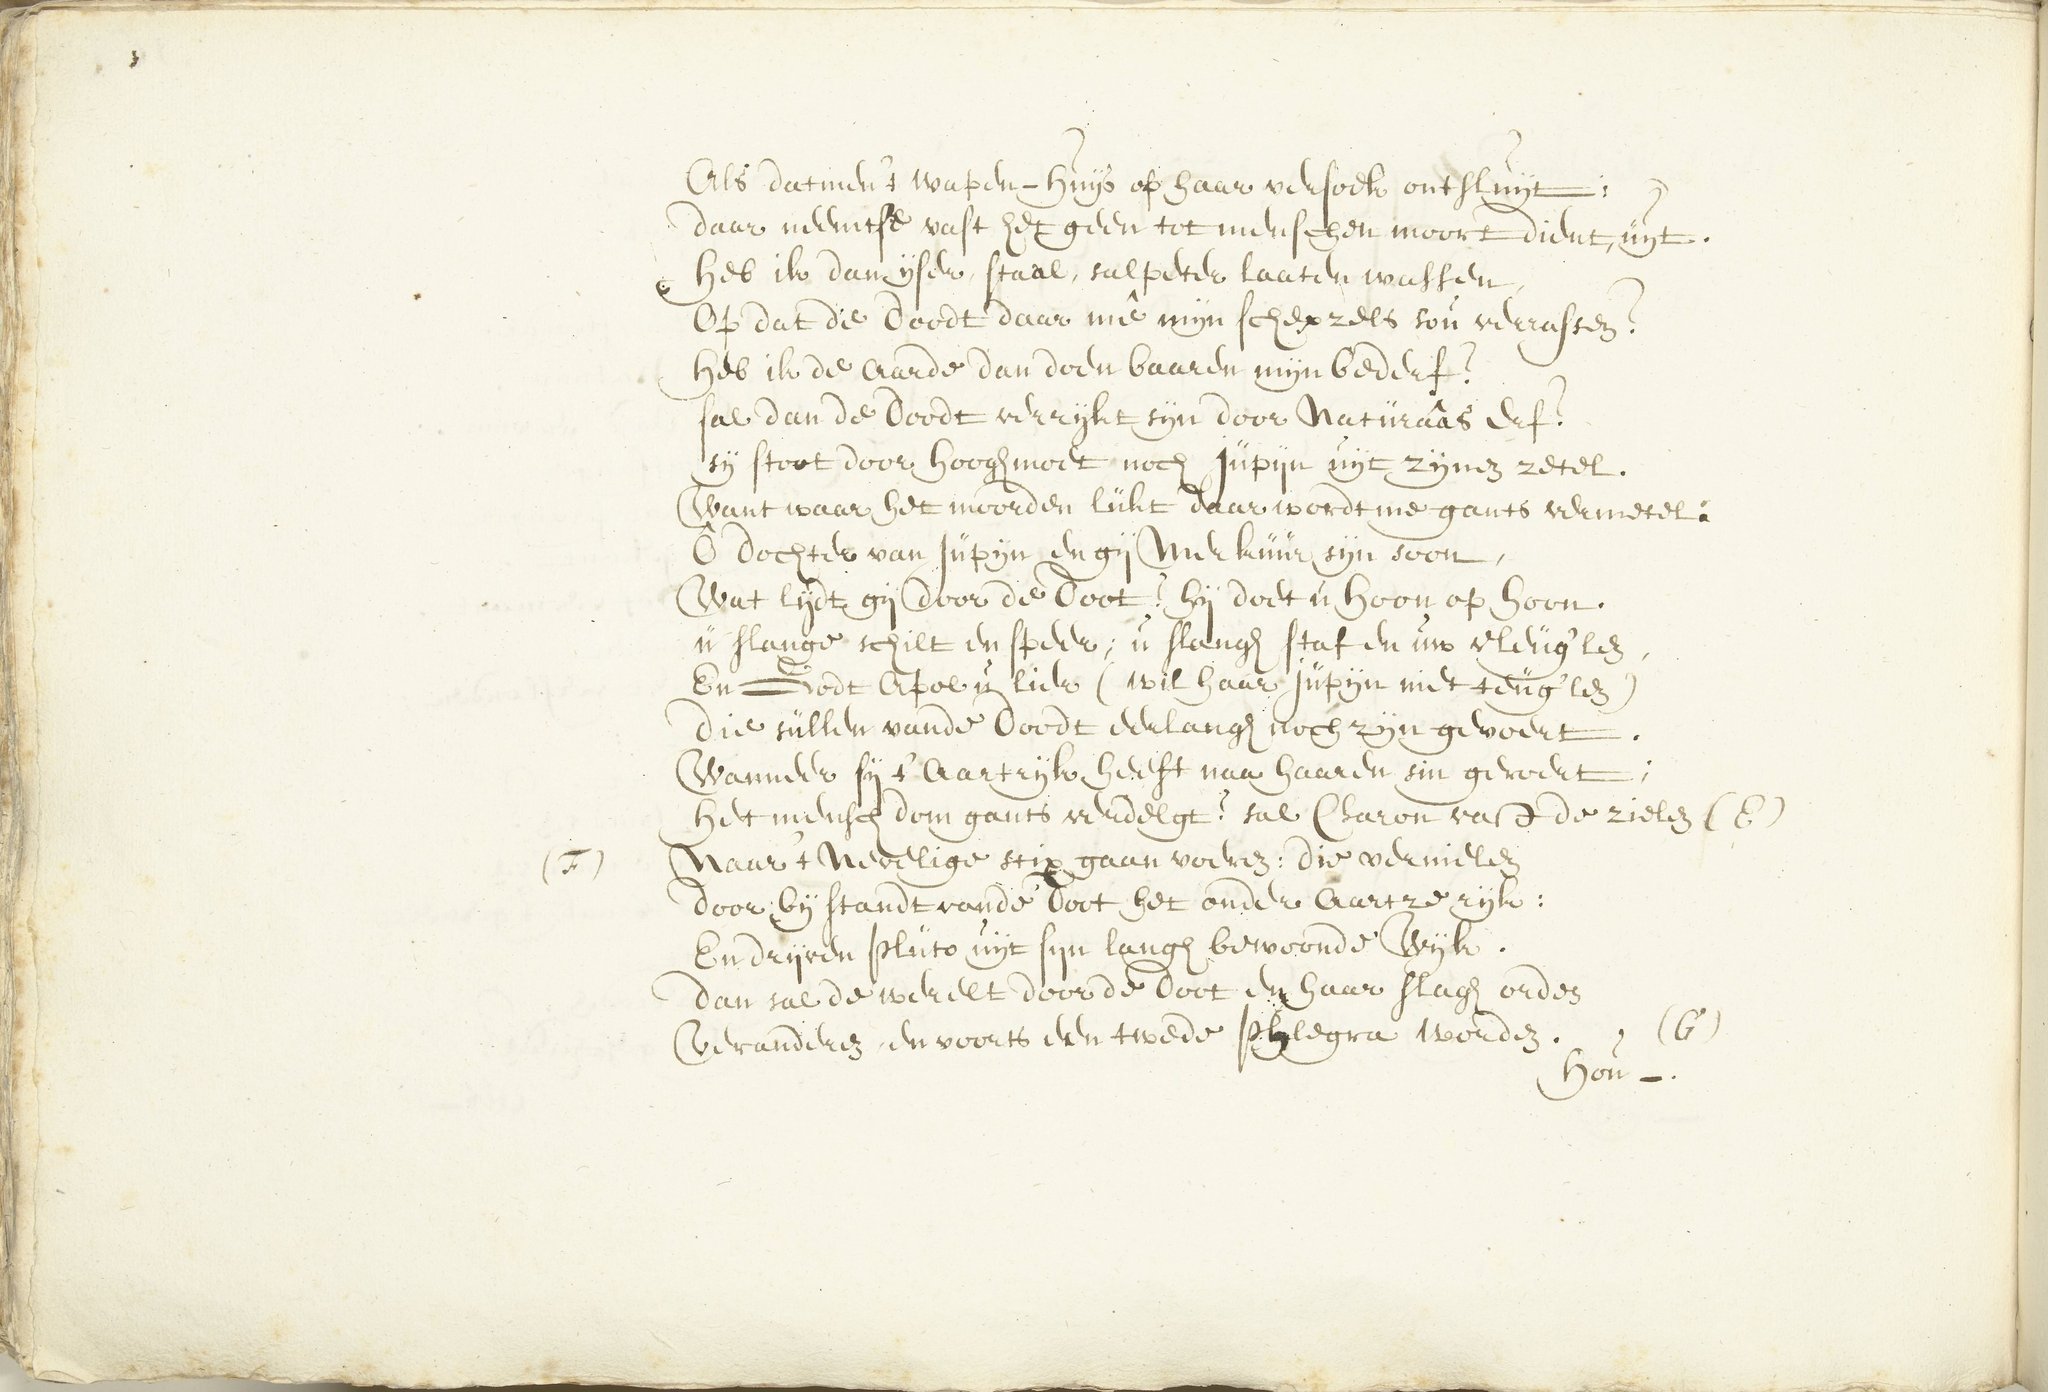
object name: text sheet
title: Strijd tussen Dood en Natuur of Zege der Schilderkunst (deel 4)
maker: henrik jordis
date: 1660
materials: ink, paper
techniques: writing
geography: zwolle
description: Vervolg van het toneelstuk Gooden Pleijdt ofte Triomphe der Schilderconst over de Doodt. In het toneelstuk beraden Apollo, Mercurius, Pallas Athene en Natuur zich over de manier waarop de Dood overwonnen kan worden en roepen zij de hulp van Schilderkunst in.